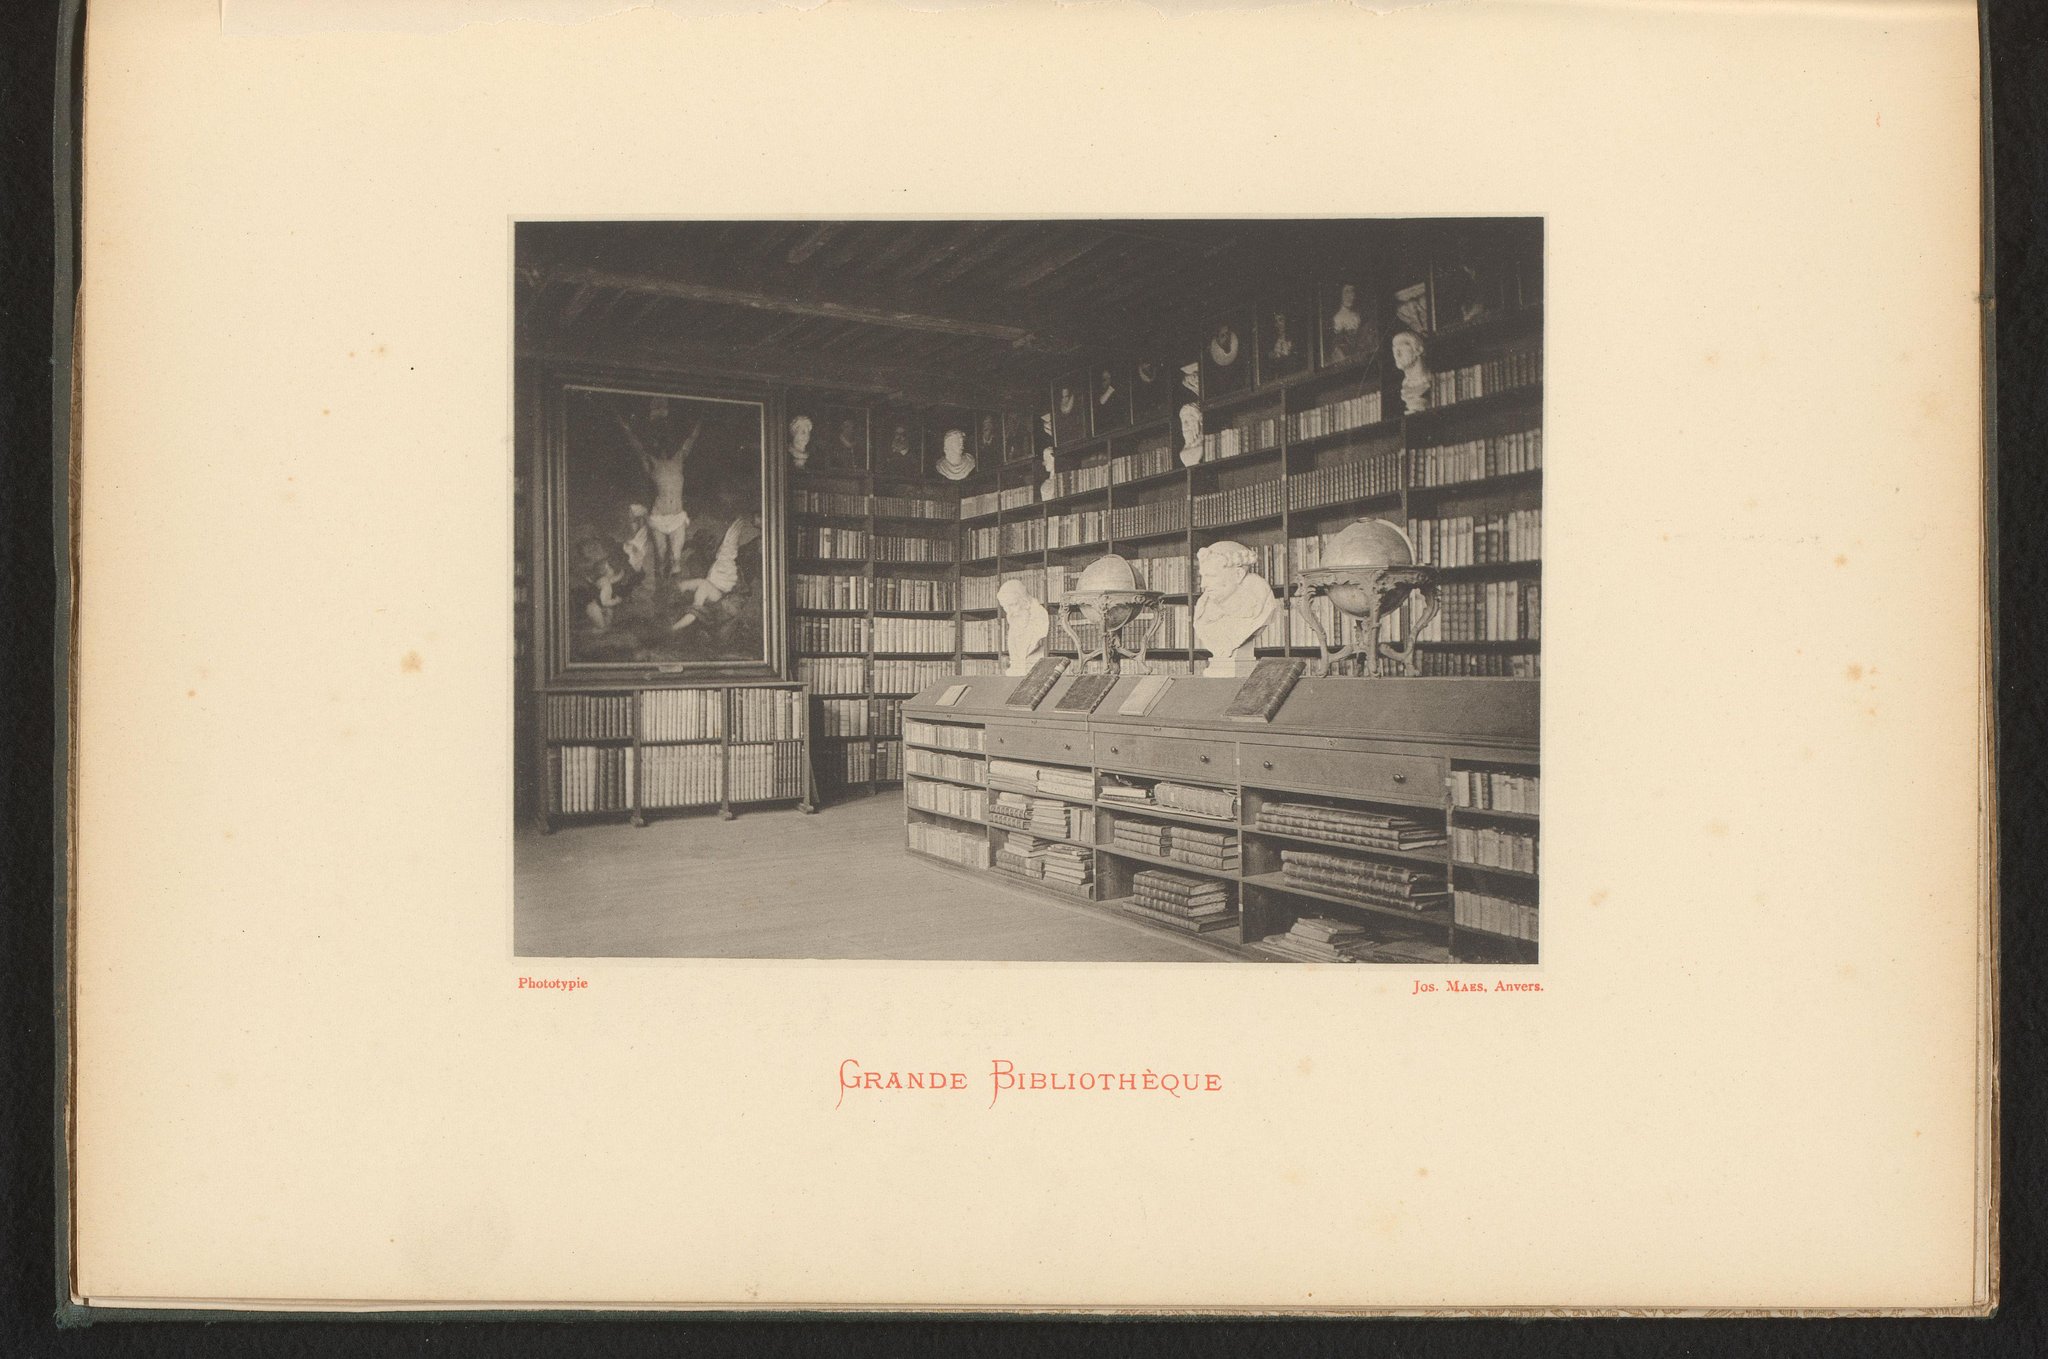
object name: photomechanical print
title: Interieur van de bibliotheek in het huis van Christoffel Plantijn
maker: joseph maes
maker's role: fotograaf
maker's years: 1838-1908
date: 1877-1882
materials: paper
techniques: photograph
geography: antwerp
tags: study; 'studiolo'; library